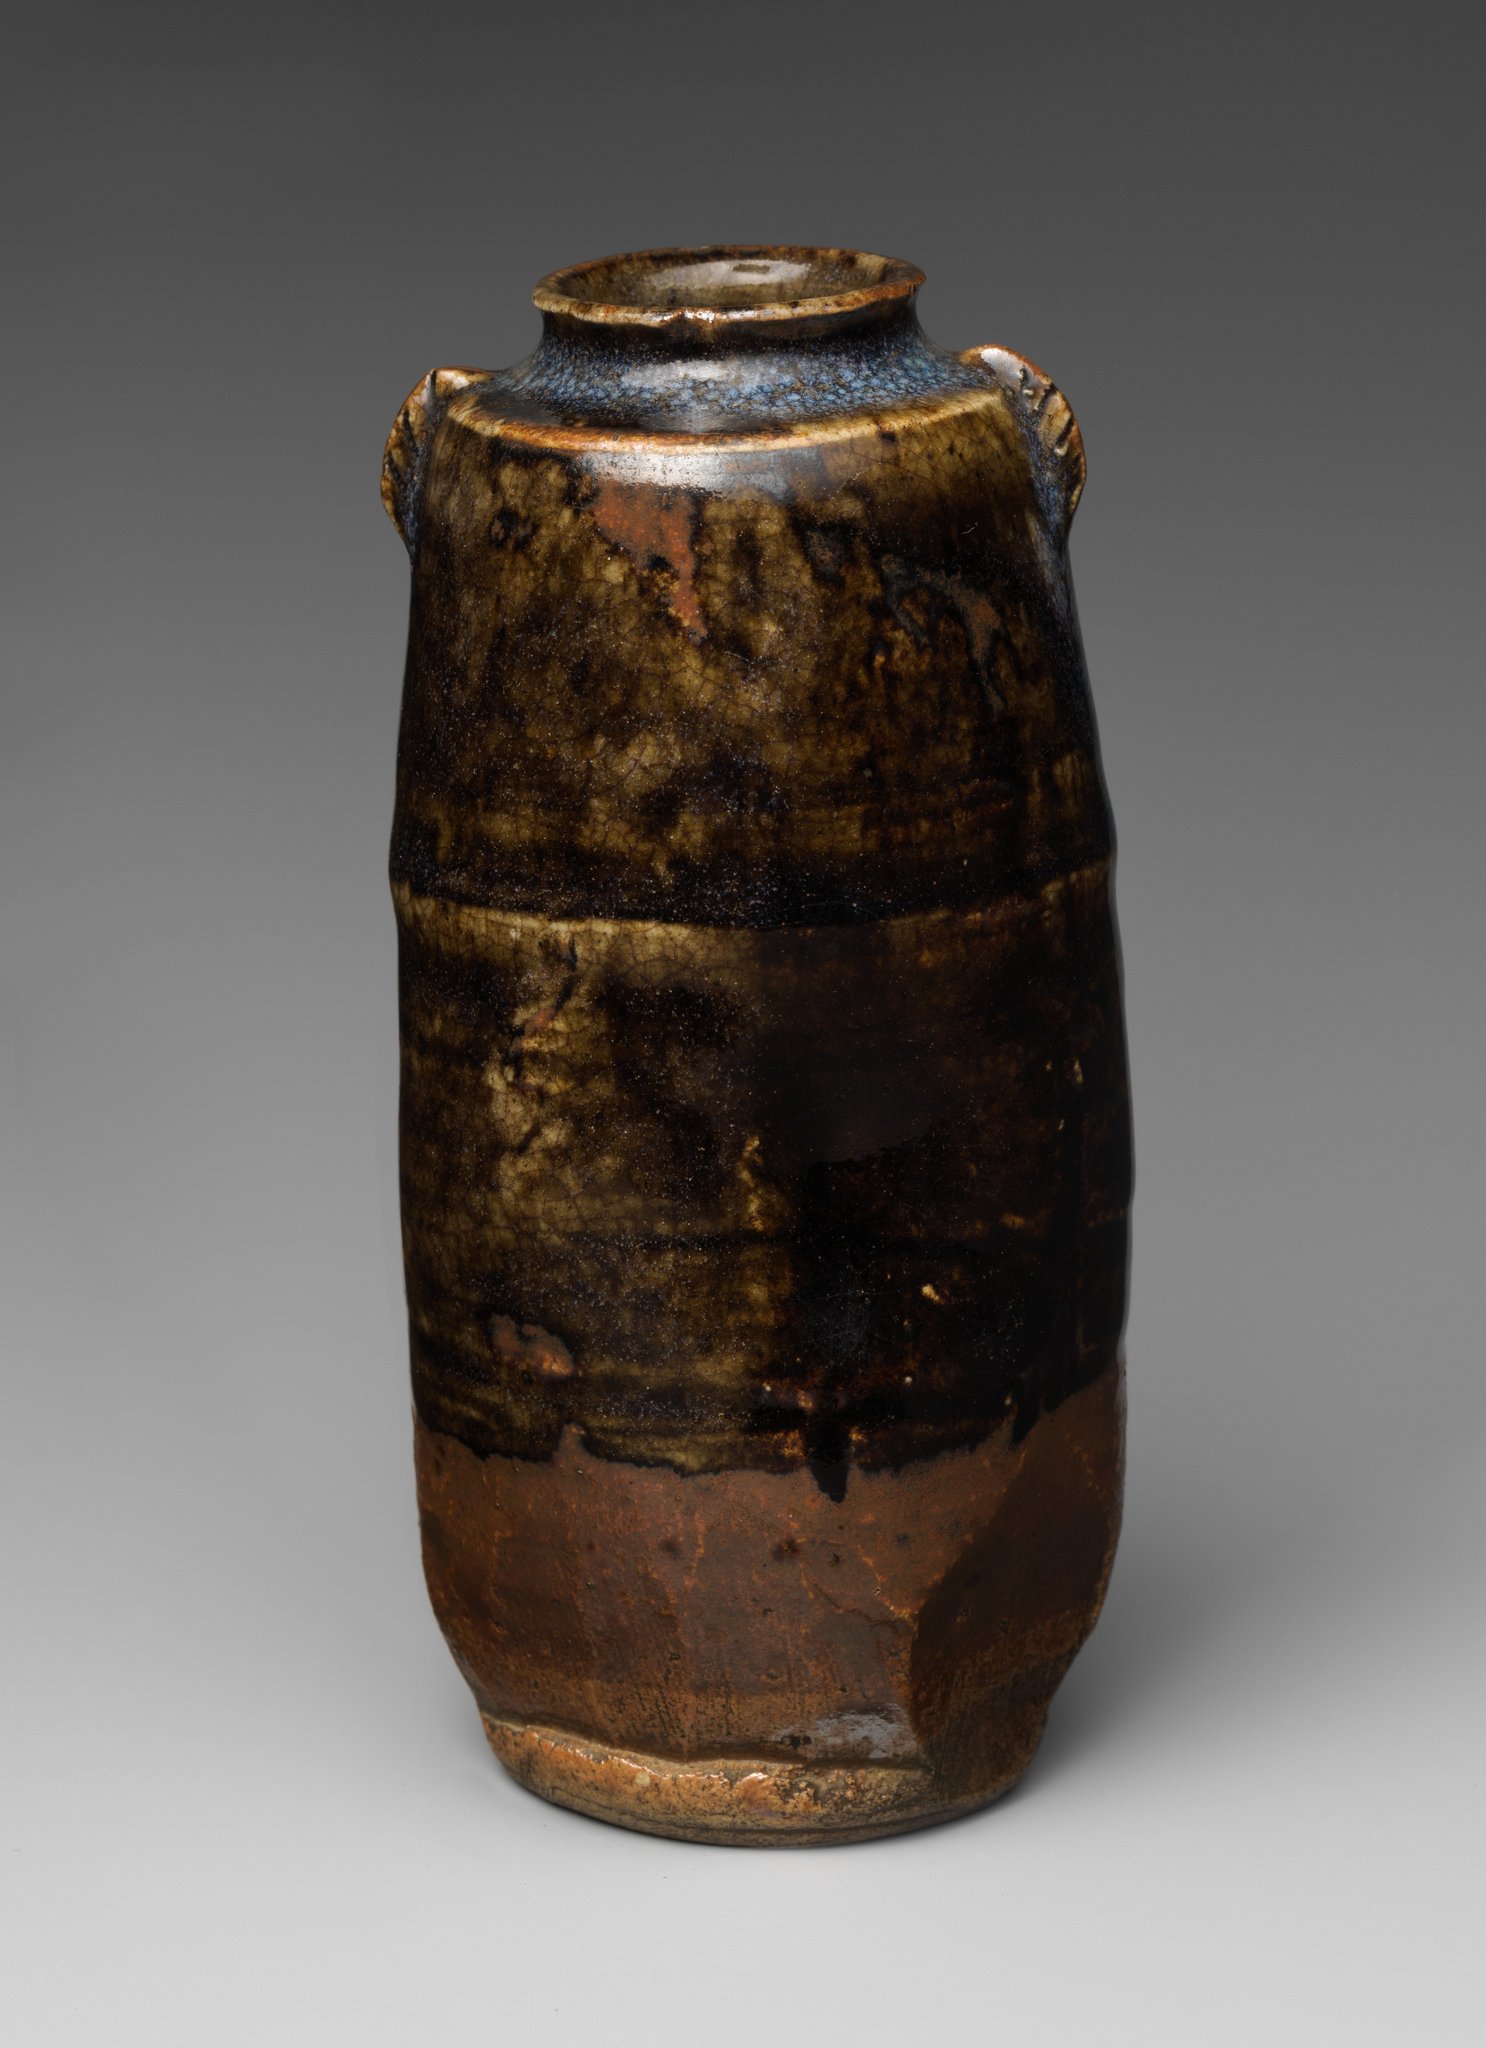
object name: tea jar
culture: japanese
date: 1701-1800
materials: clay, glaze